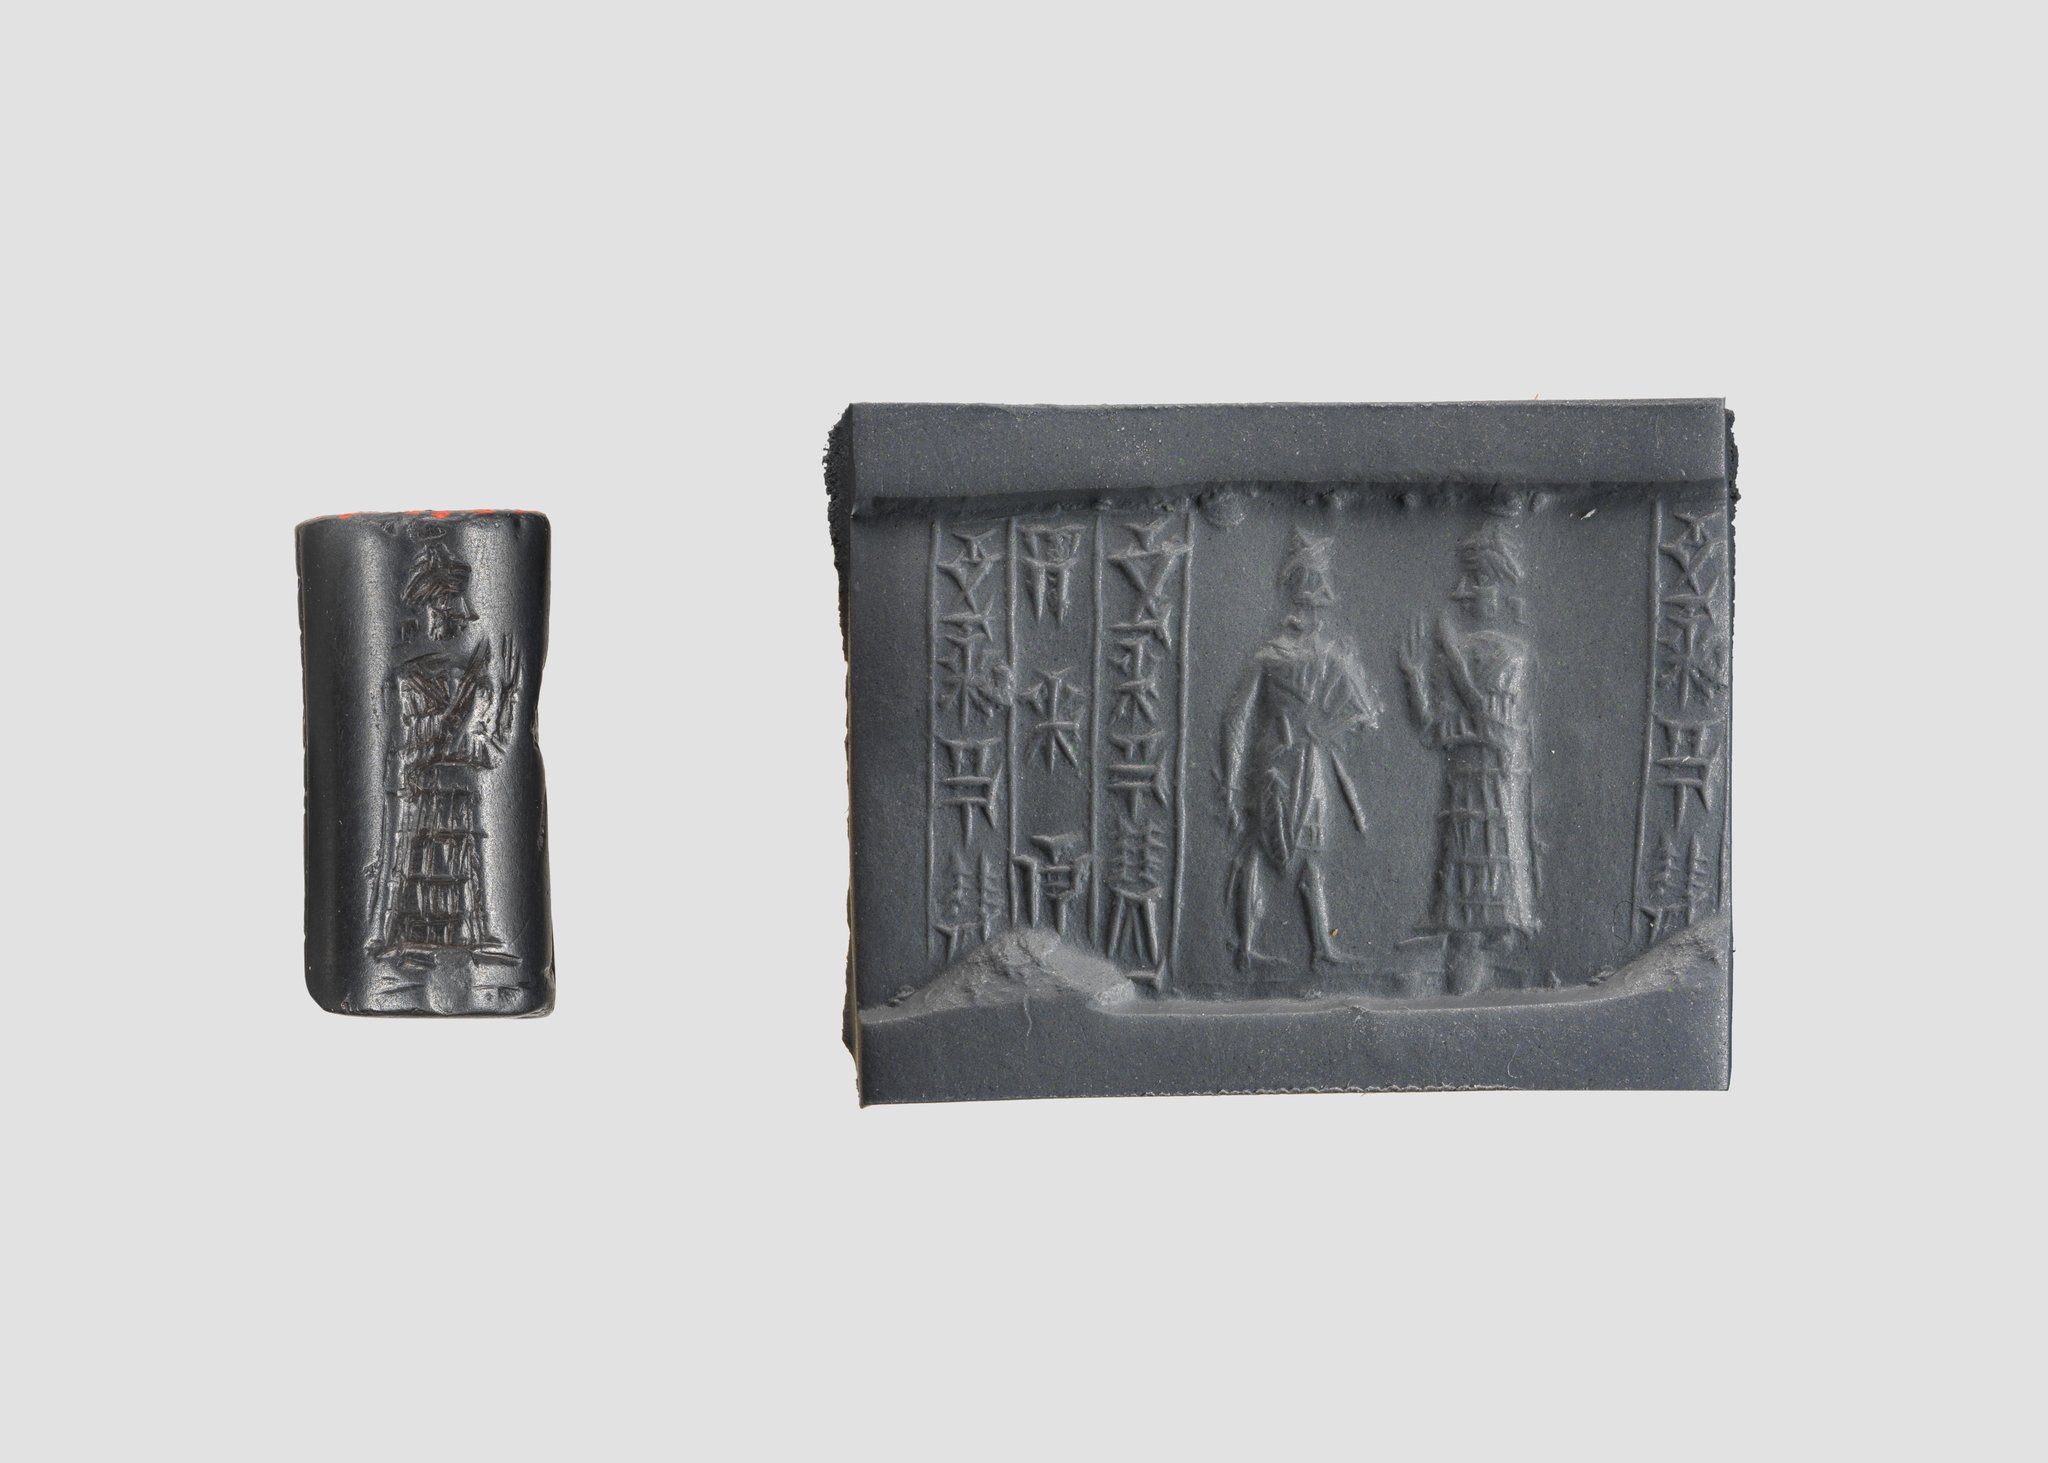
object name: cylinder seal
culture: babylonian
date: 2000-1668 BCE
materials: mineral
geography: mesopotamia